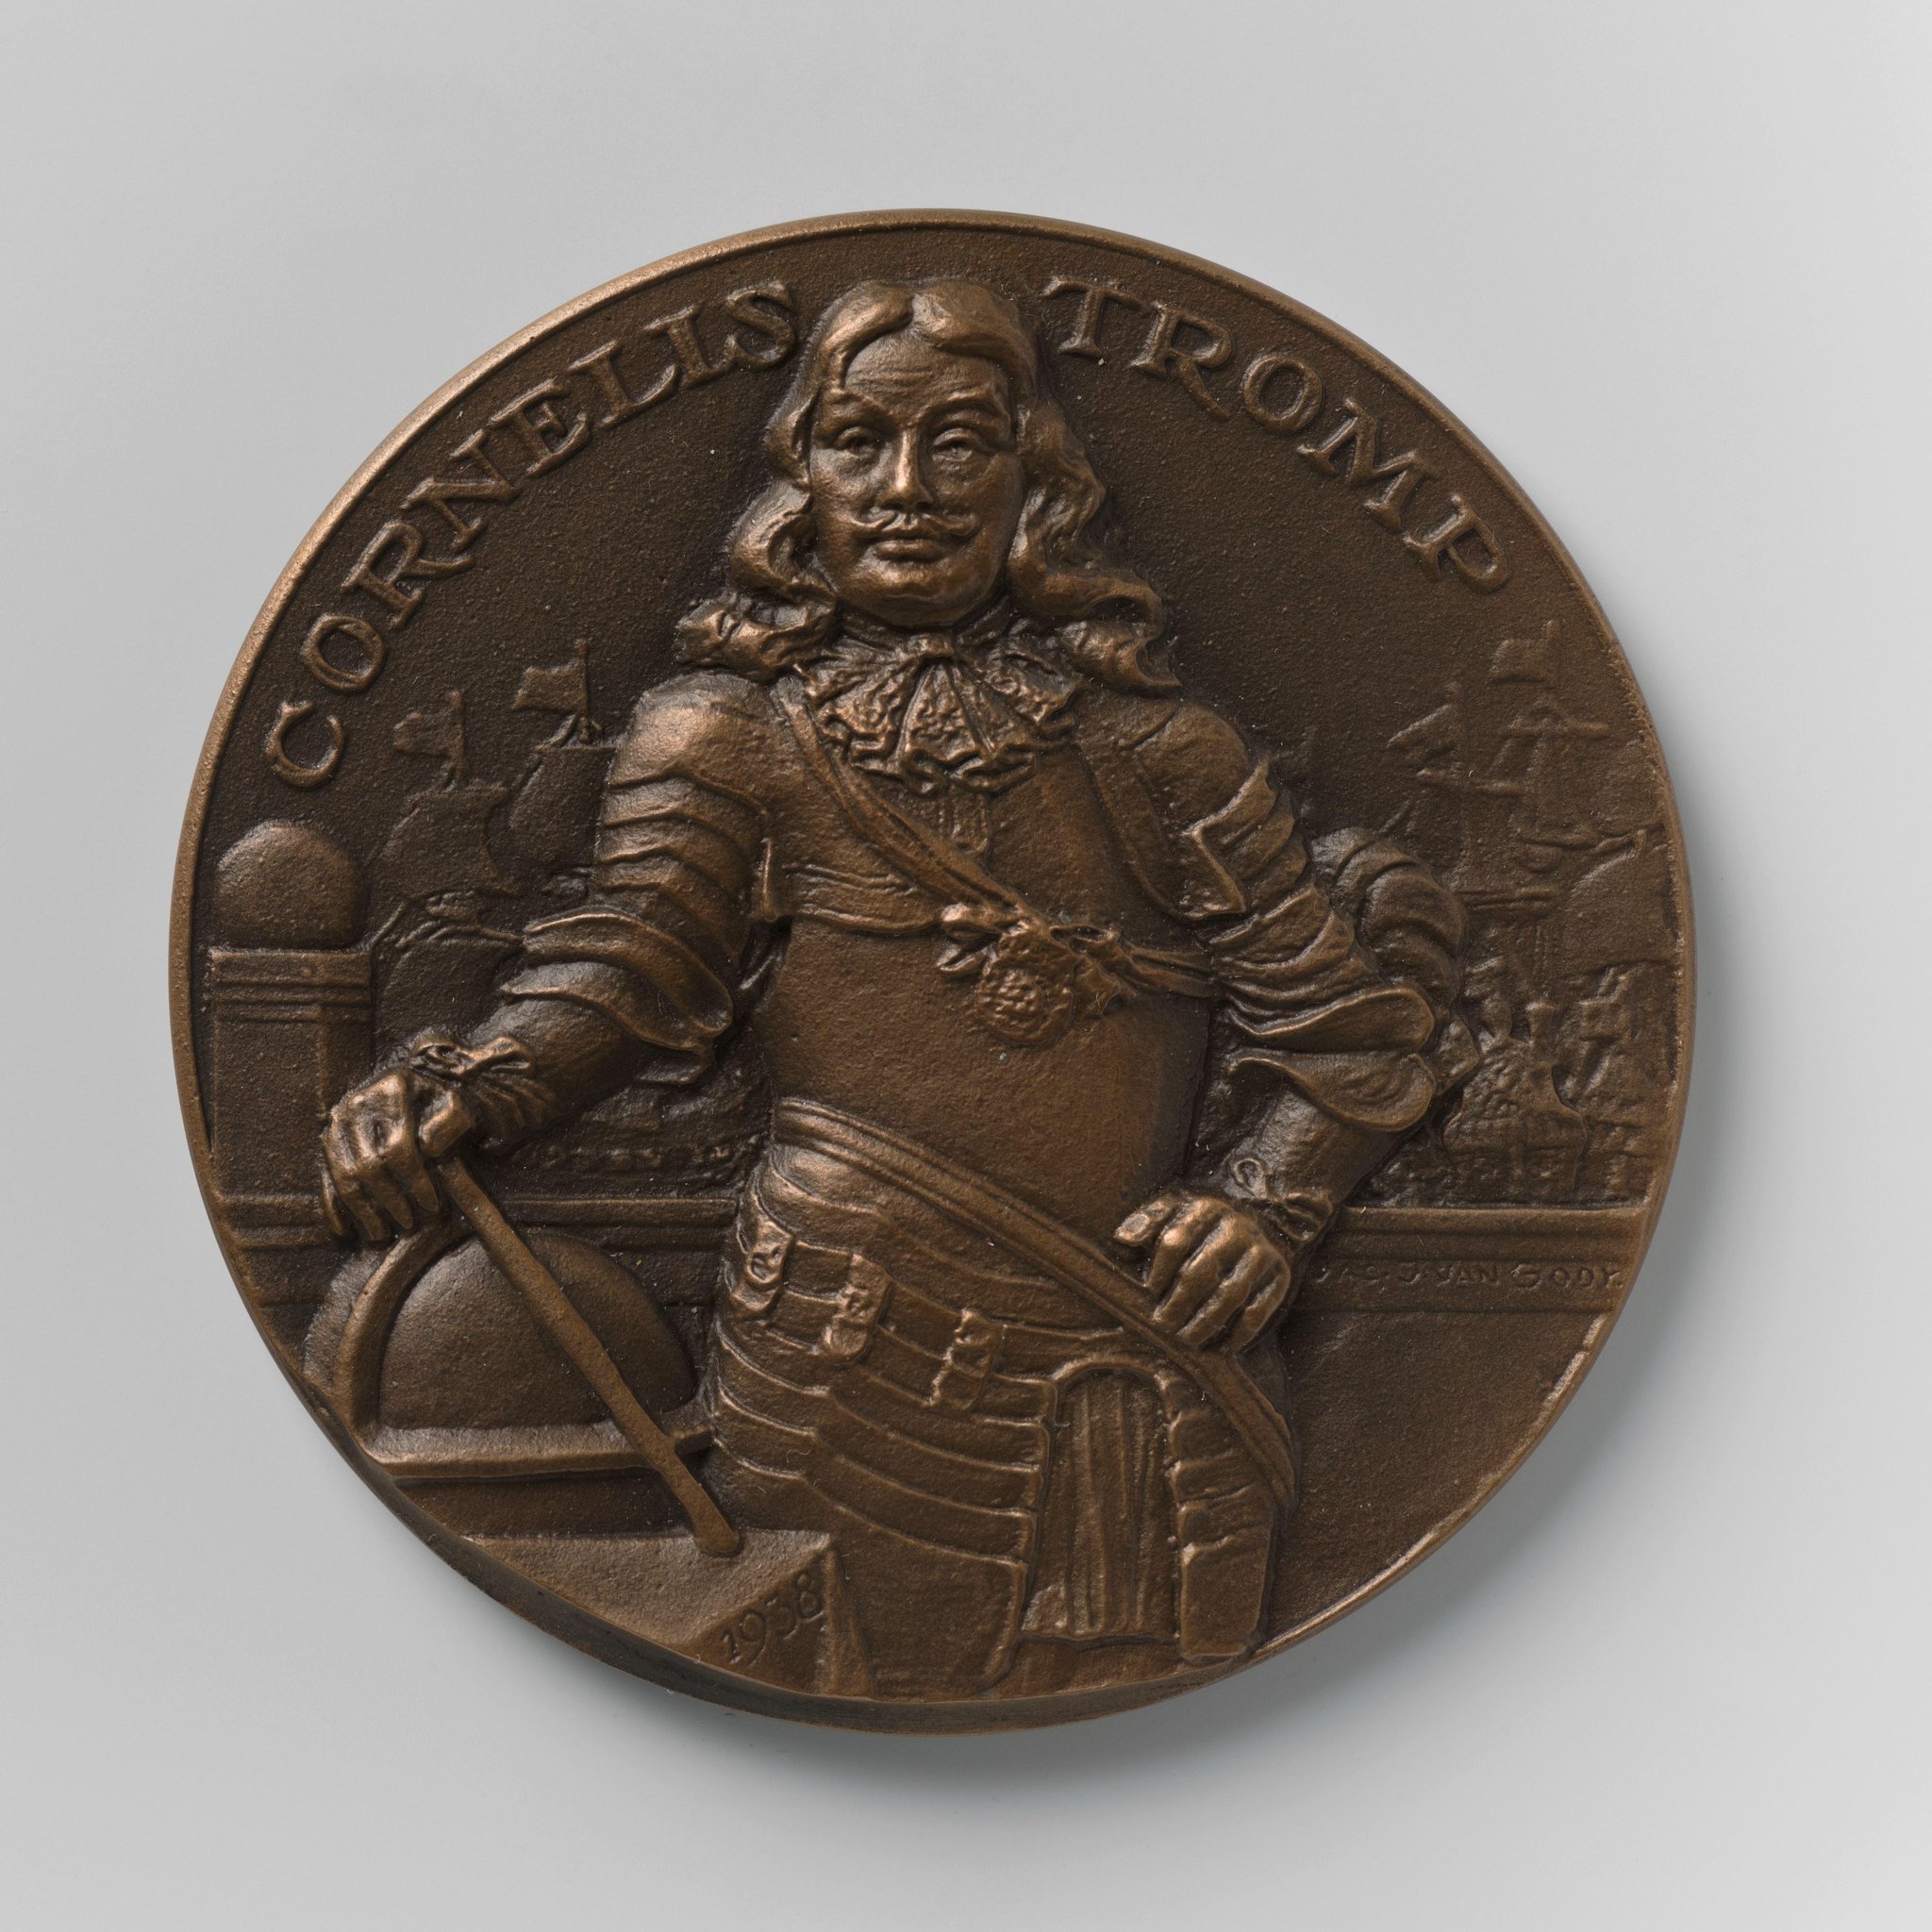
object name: history medal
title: Cornelis Tromp 1938 met randinscriptie 1941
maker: jacob jan van goor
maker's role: medailleur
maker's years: 1874-1956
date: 1938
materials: bronze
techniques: striking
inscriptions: inscription: ‘HERSTEL DOET WEL - O.Z. VOORBURGWAL 136 - AMSTERDAM - NAJAAR 1941’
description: Bronzen penning, op de voorzijde Tromp met harnas en staf, op de achtergrond schepen en met omschrift bovenaan, op de keerzijde een masttop waarop een bezem, op de ra drie wapenschilden, op de achtergrond een zeeslag met één regel tekst, met omschrift, met randinscriptie uit 1941.